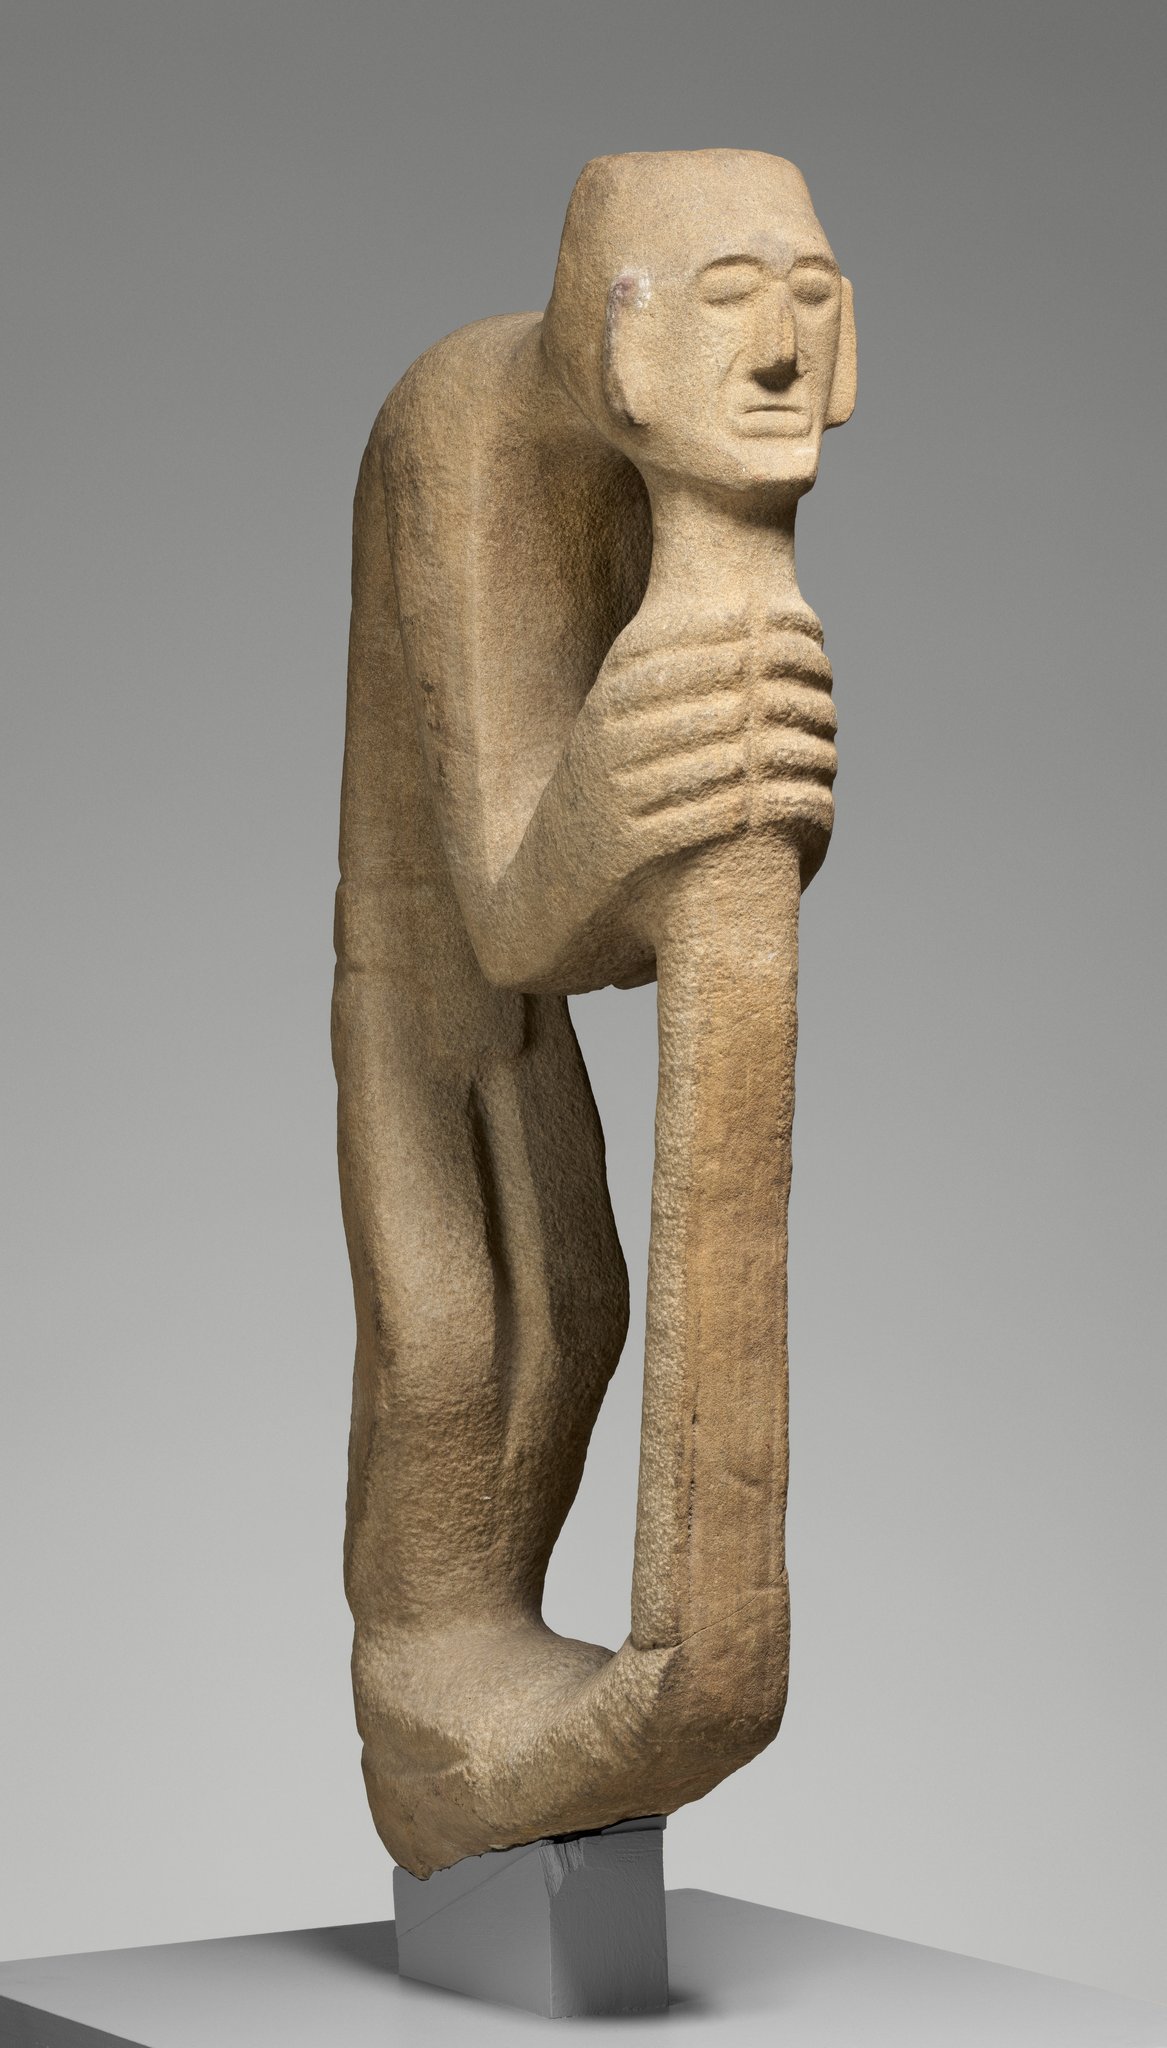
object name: figure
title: Agricultural deity with digging stick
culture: huastec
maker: huastec artist(s)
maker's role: artist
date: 900-1521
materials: stone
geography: mexico